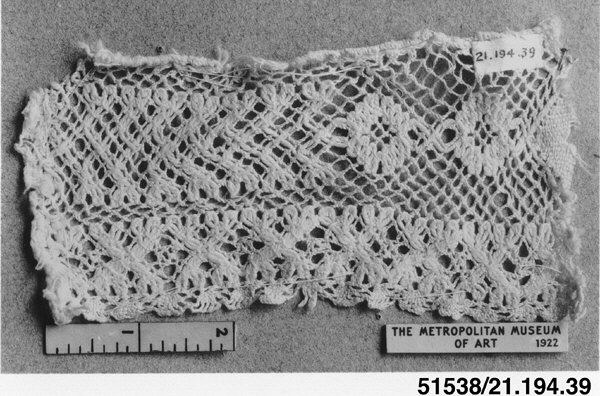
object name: fragment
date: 1834-1866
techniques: lace